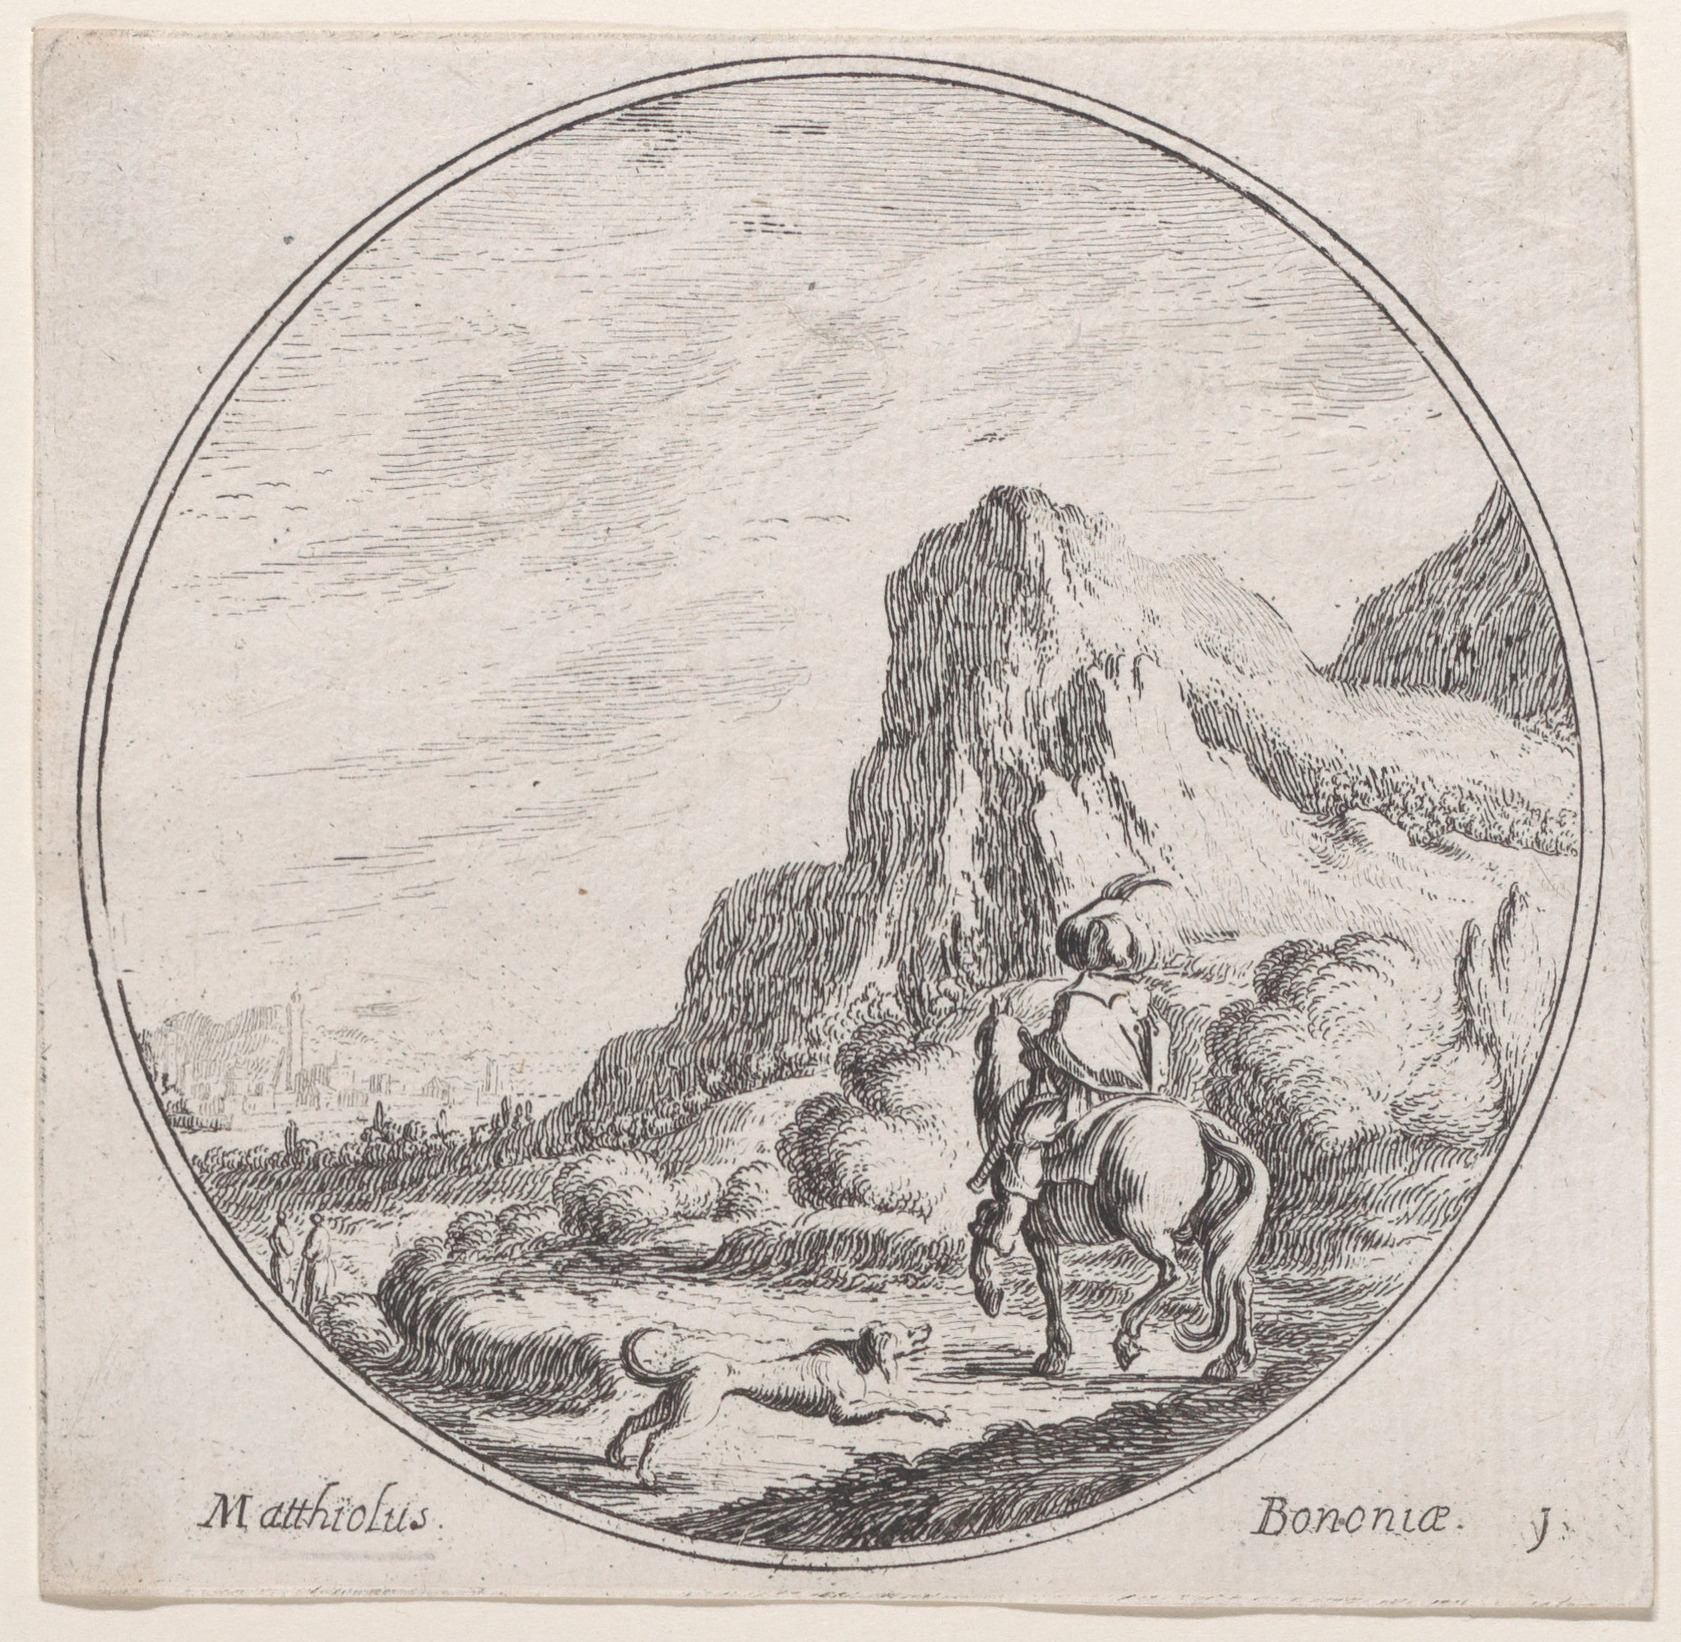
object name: print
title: Plate 1: a horseman riding towards the left, followed by a dog, in a rocky landscape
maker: lodovico mattioli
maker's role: artist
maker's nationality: italian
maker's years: 1662-1747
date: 1680-1747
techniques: etching